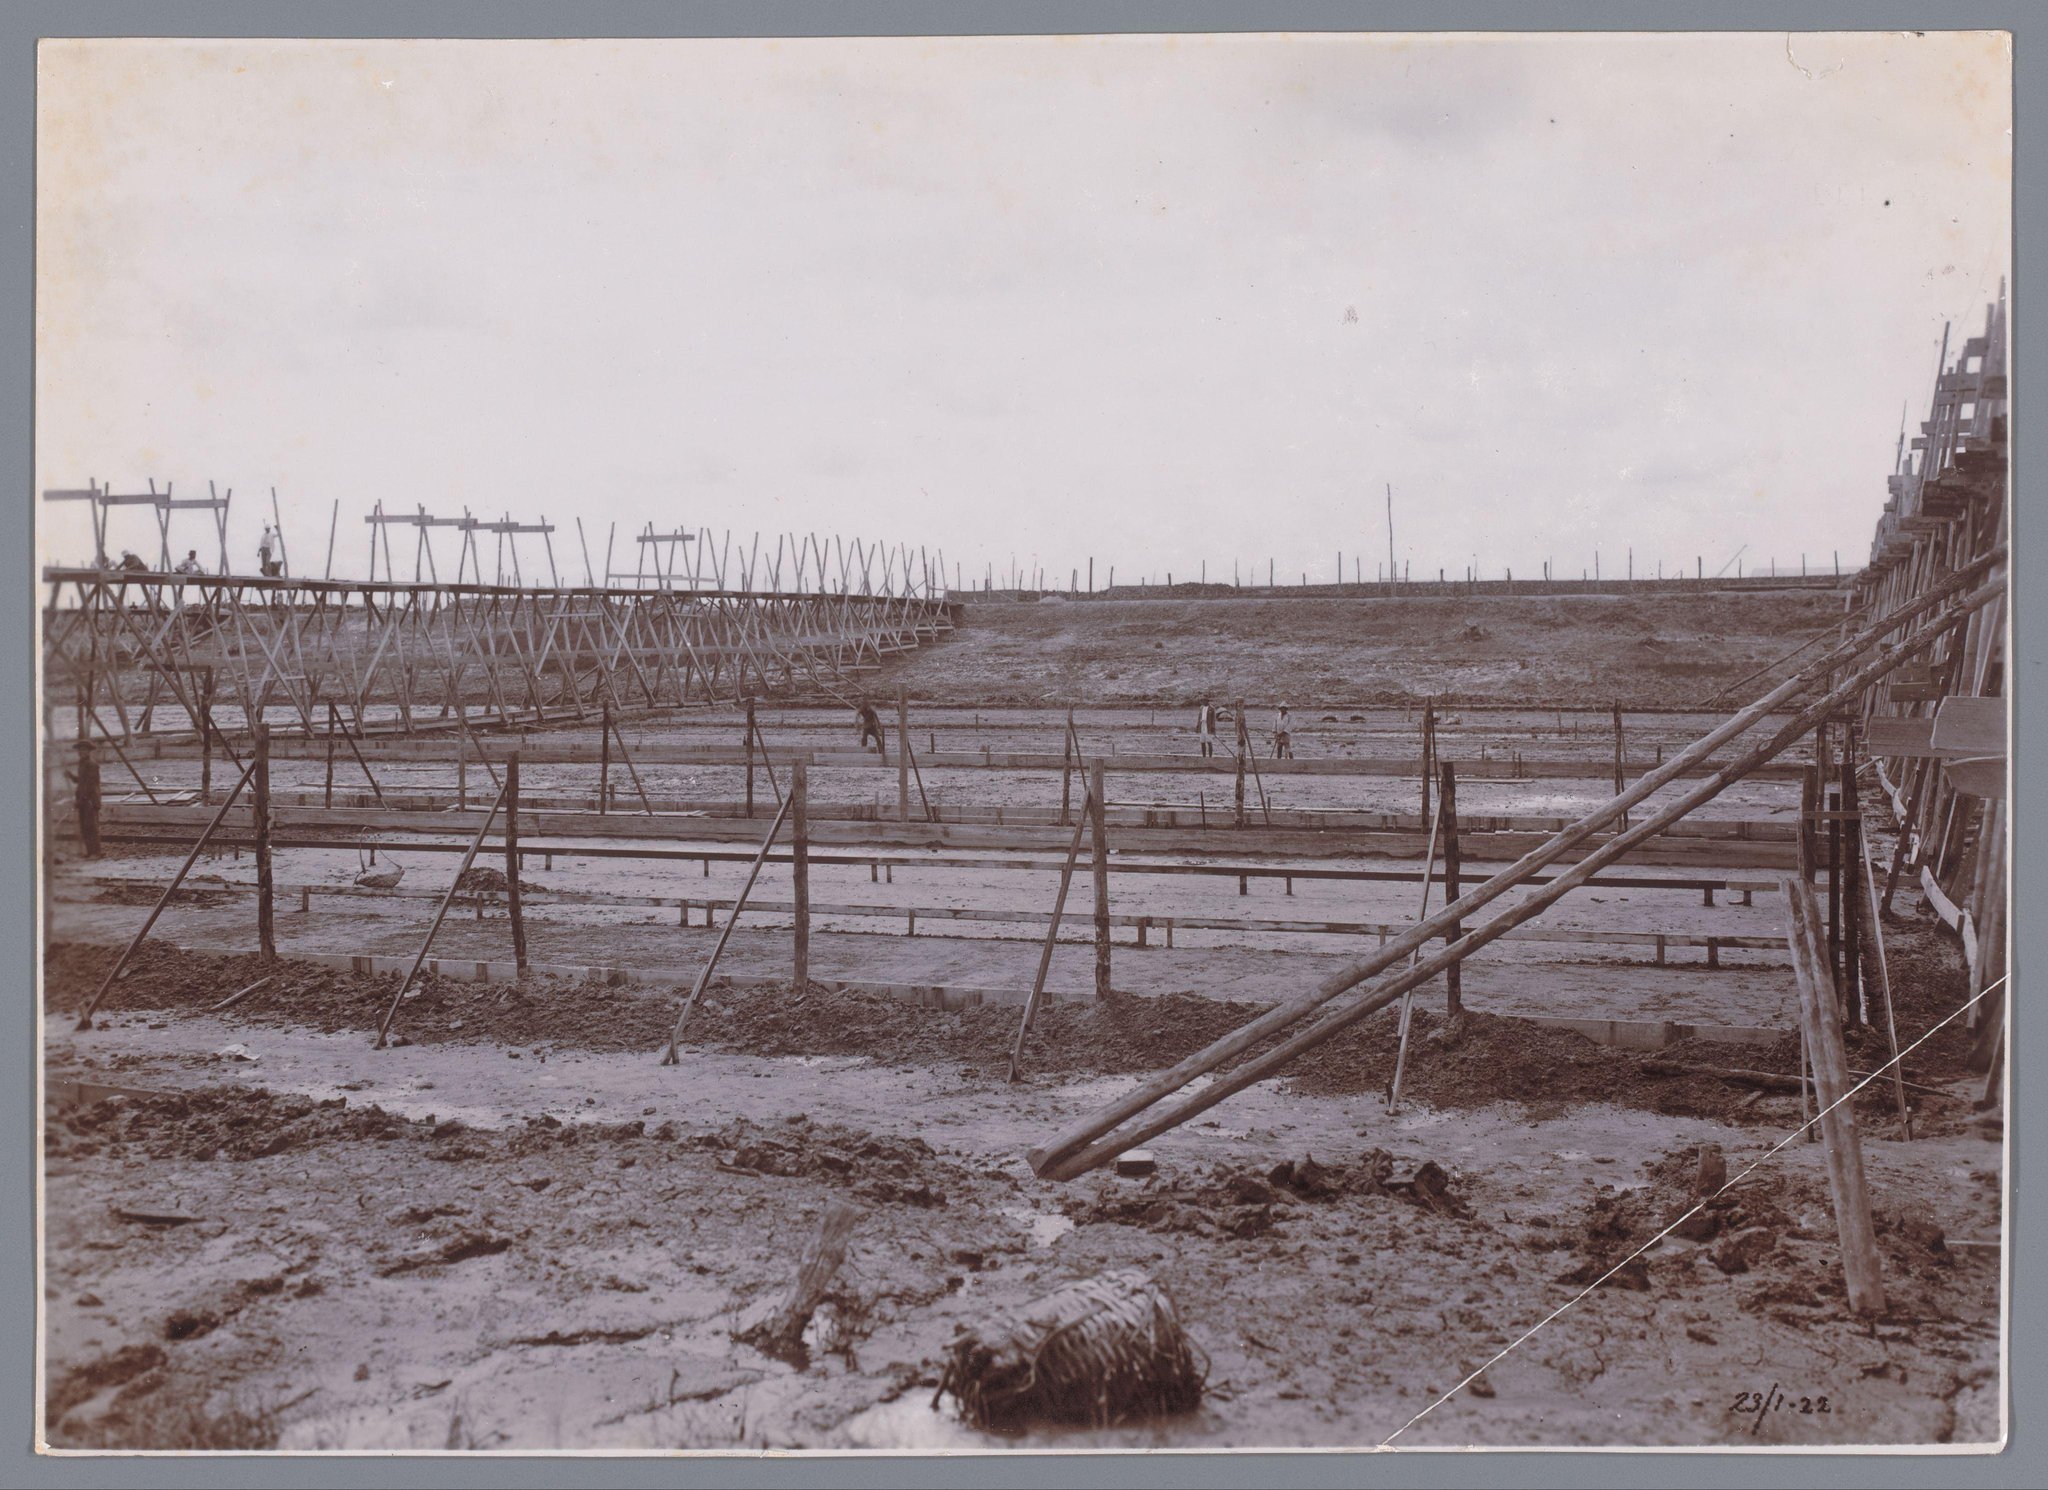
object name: photograph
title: Plaatsen voetplanken en bodem gelijktrekken der vloeren van 2e/2 caissons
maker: Anonymous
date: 1922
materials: photographic support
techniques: gelatin silver print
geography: belawan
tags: harbour, building-site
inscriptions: inscription: ‘No 111 plaatsen voetplanken en bodem gelijktrekken der vloeren van 2e/2 caissons’, date: ‘23/1-22’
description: Plaatsen van loopplanken en egaliseren van de vloeren van de caissons. Genummerd: 111. Onderdeel van de groep van losse foto's over de aanleg van de haven Belawan aan de kust voor Medan, Sumatra 1921-1922.